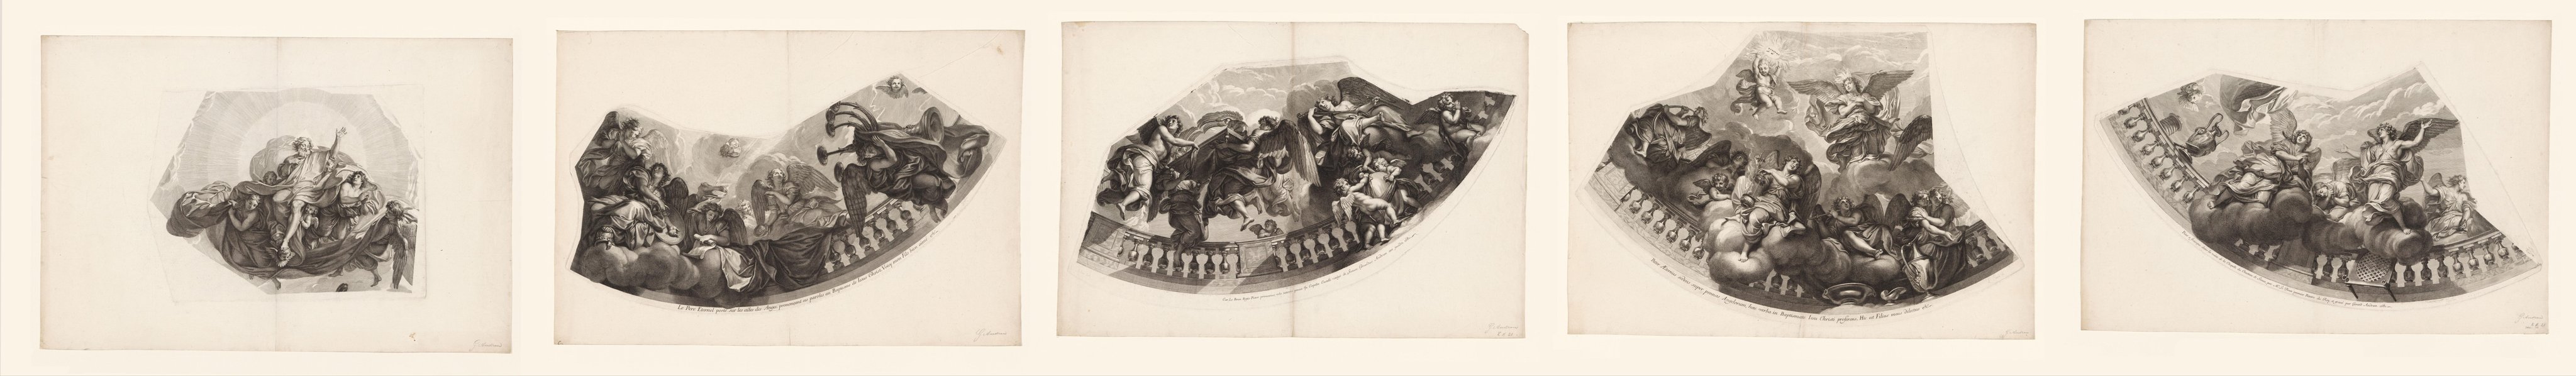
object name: print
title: Plafondschildering van de kapel van Château de Sceaux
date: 1681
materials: paper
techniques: engraving, etching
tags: god the father as bearded old man, usually with crown or tiara or sceptre and/or globe, (decorated) ceiling, angels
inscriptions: collector's mark: Lugt 1838, collector's mark: Lugt 240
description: Dit object is omwille van een betere presentatie virtueel samengevoegd, maar bestaat fysiek uit losse onderdelen.